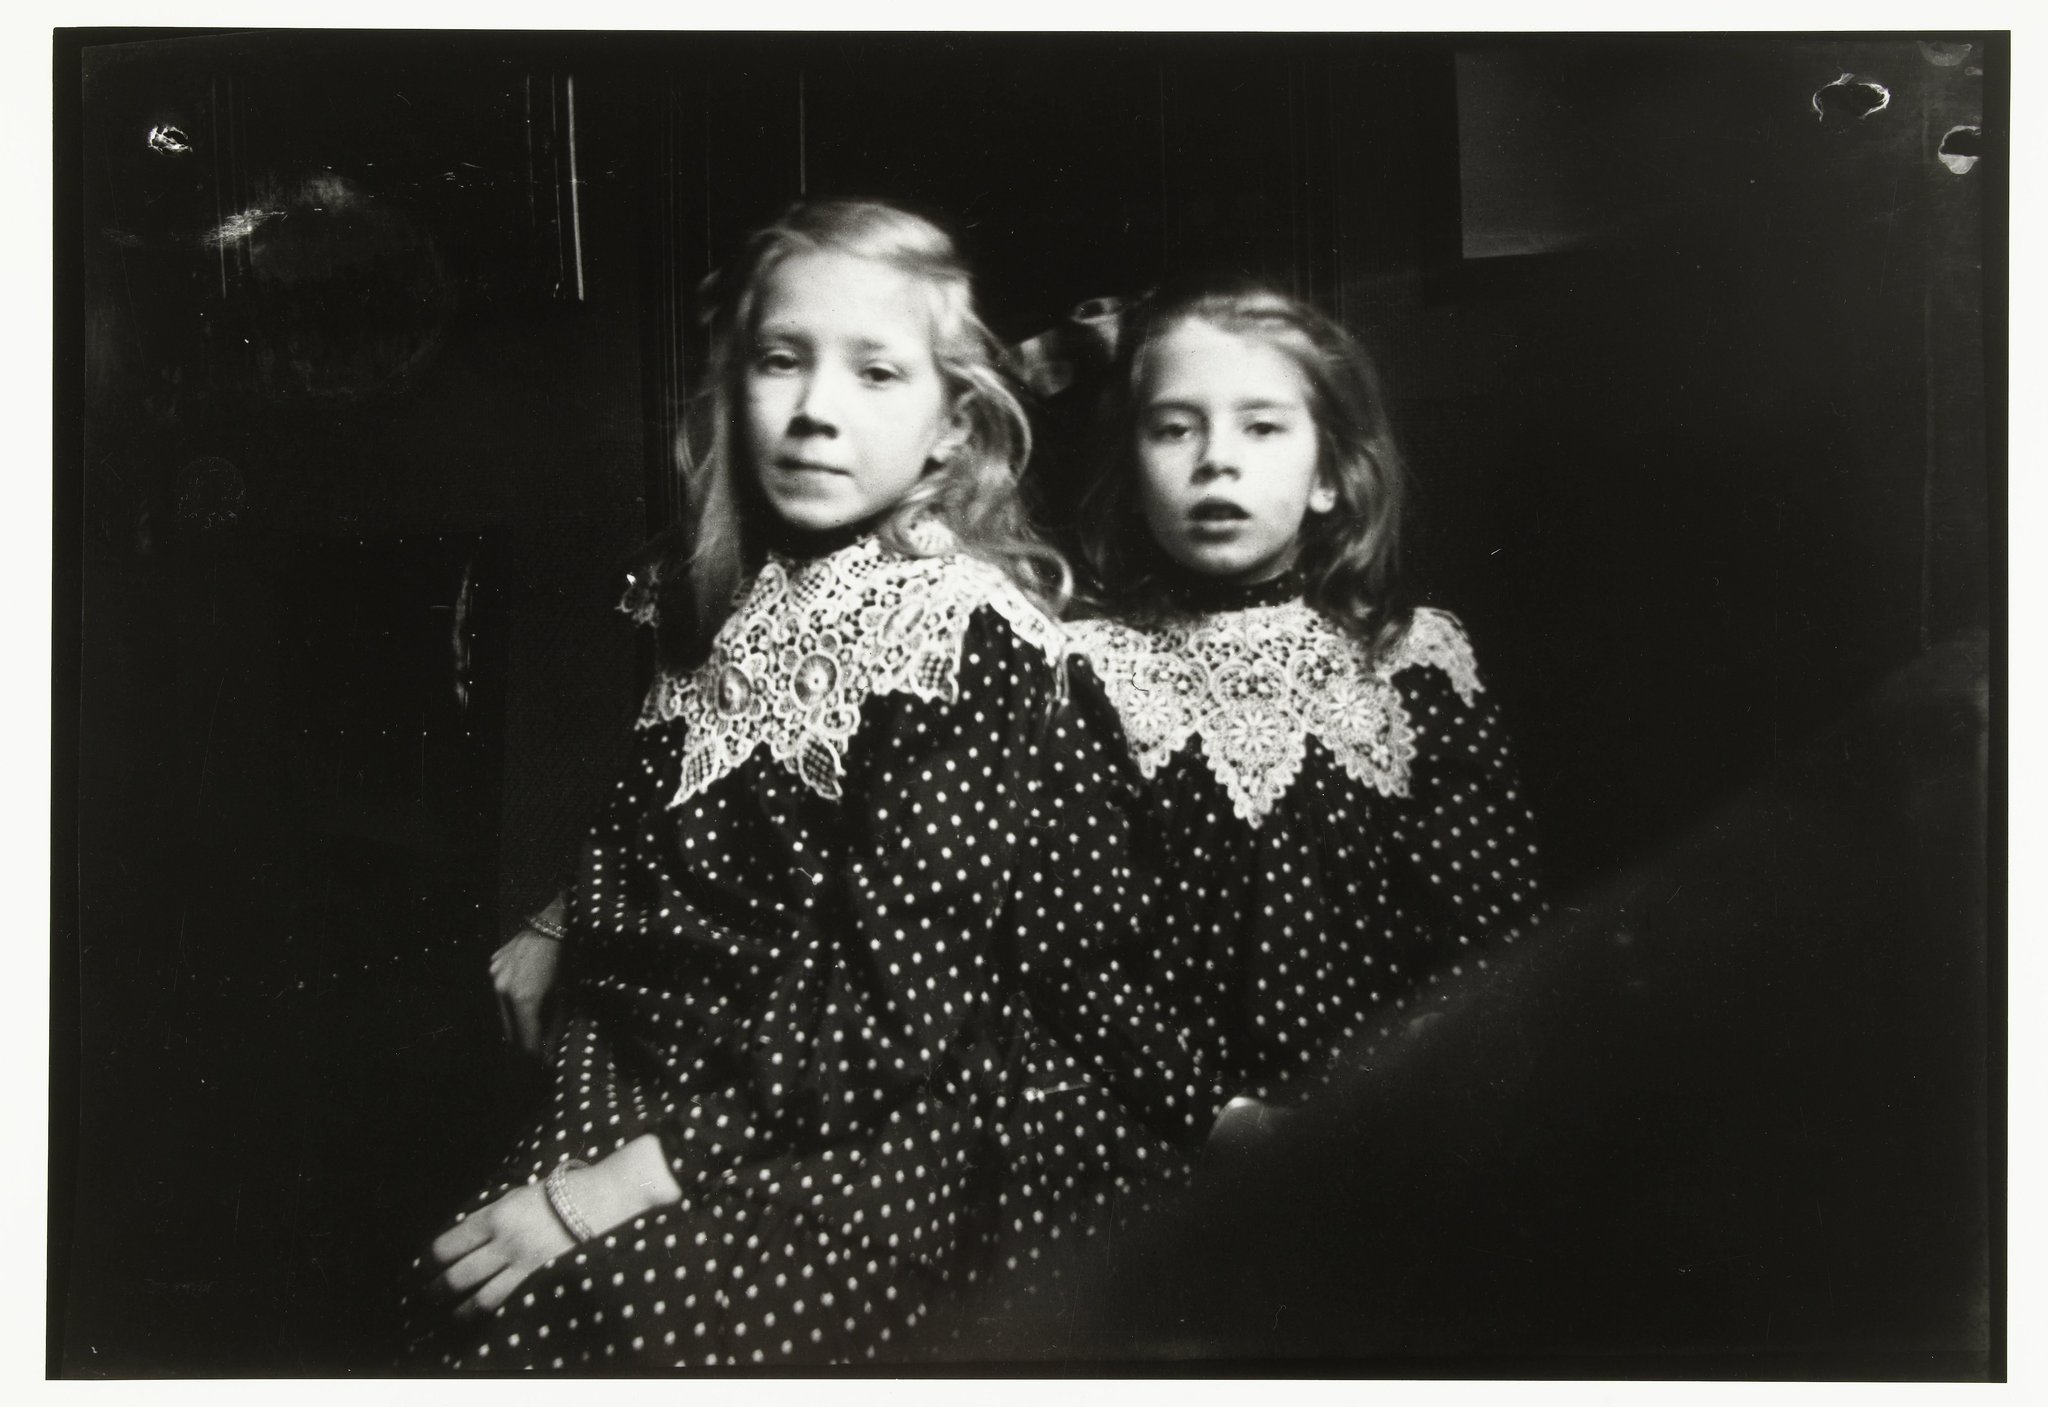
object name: photograph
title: Portret van twee onbekende meisjes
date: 1890-1910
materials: paper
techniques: gelatin silver print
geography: amsterdam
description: Moderne afdruk van negatief BR 793 (collectie RKD).